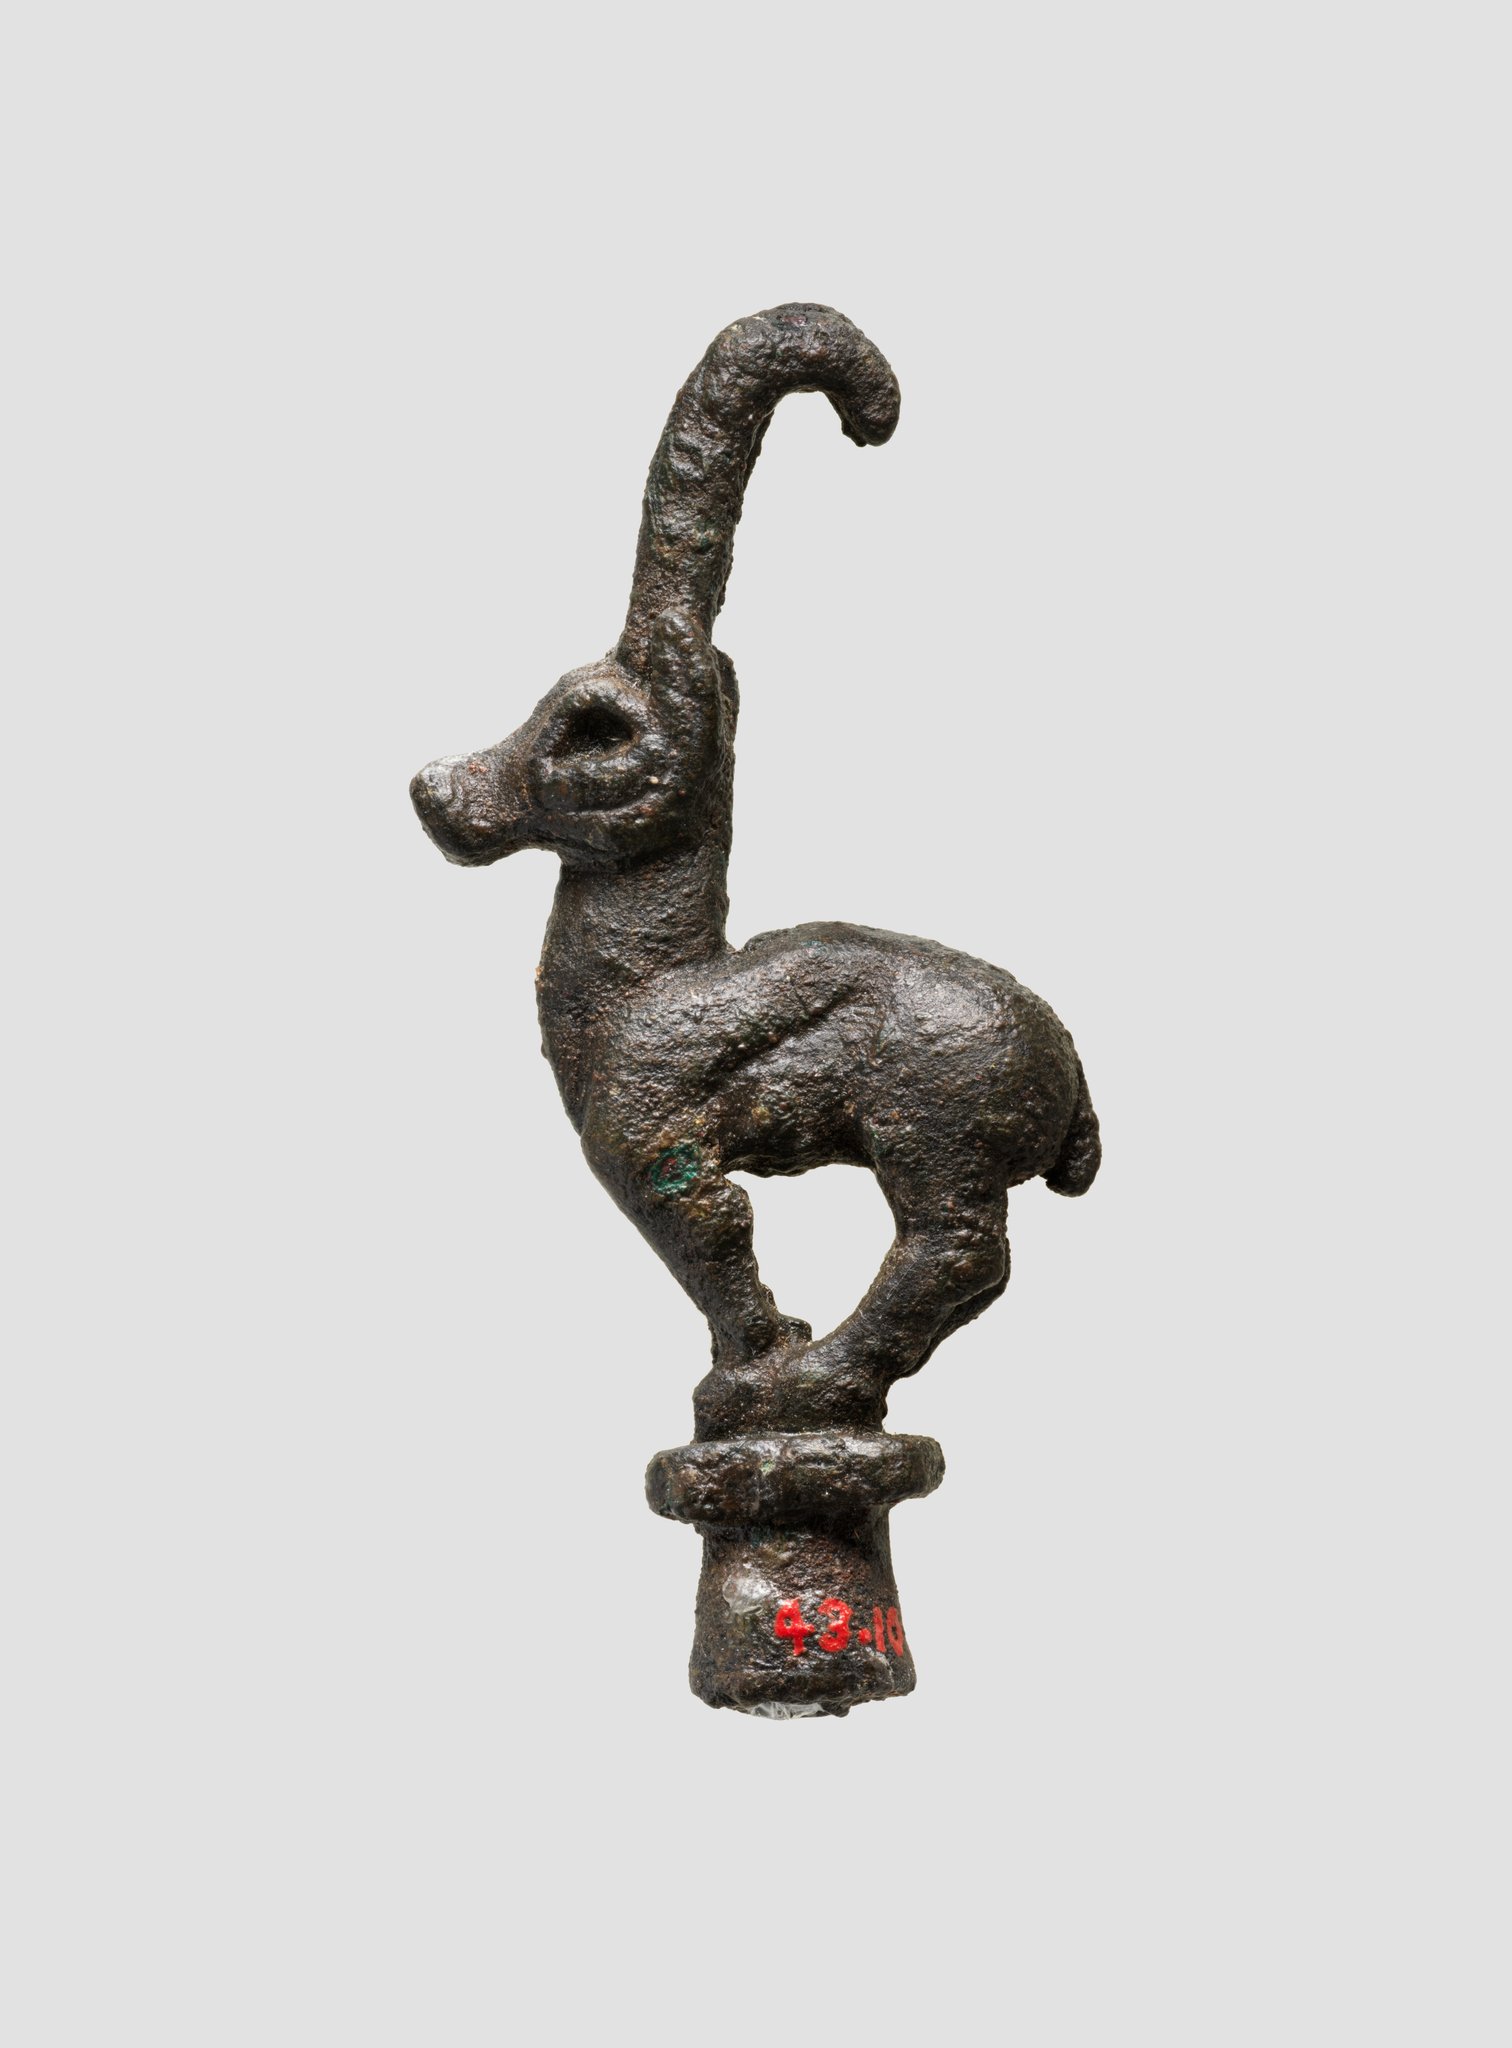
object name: pin head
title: Head of pin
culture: iranian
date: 800-601 BCE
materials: bronze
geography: iran, luristan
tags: animals